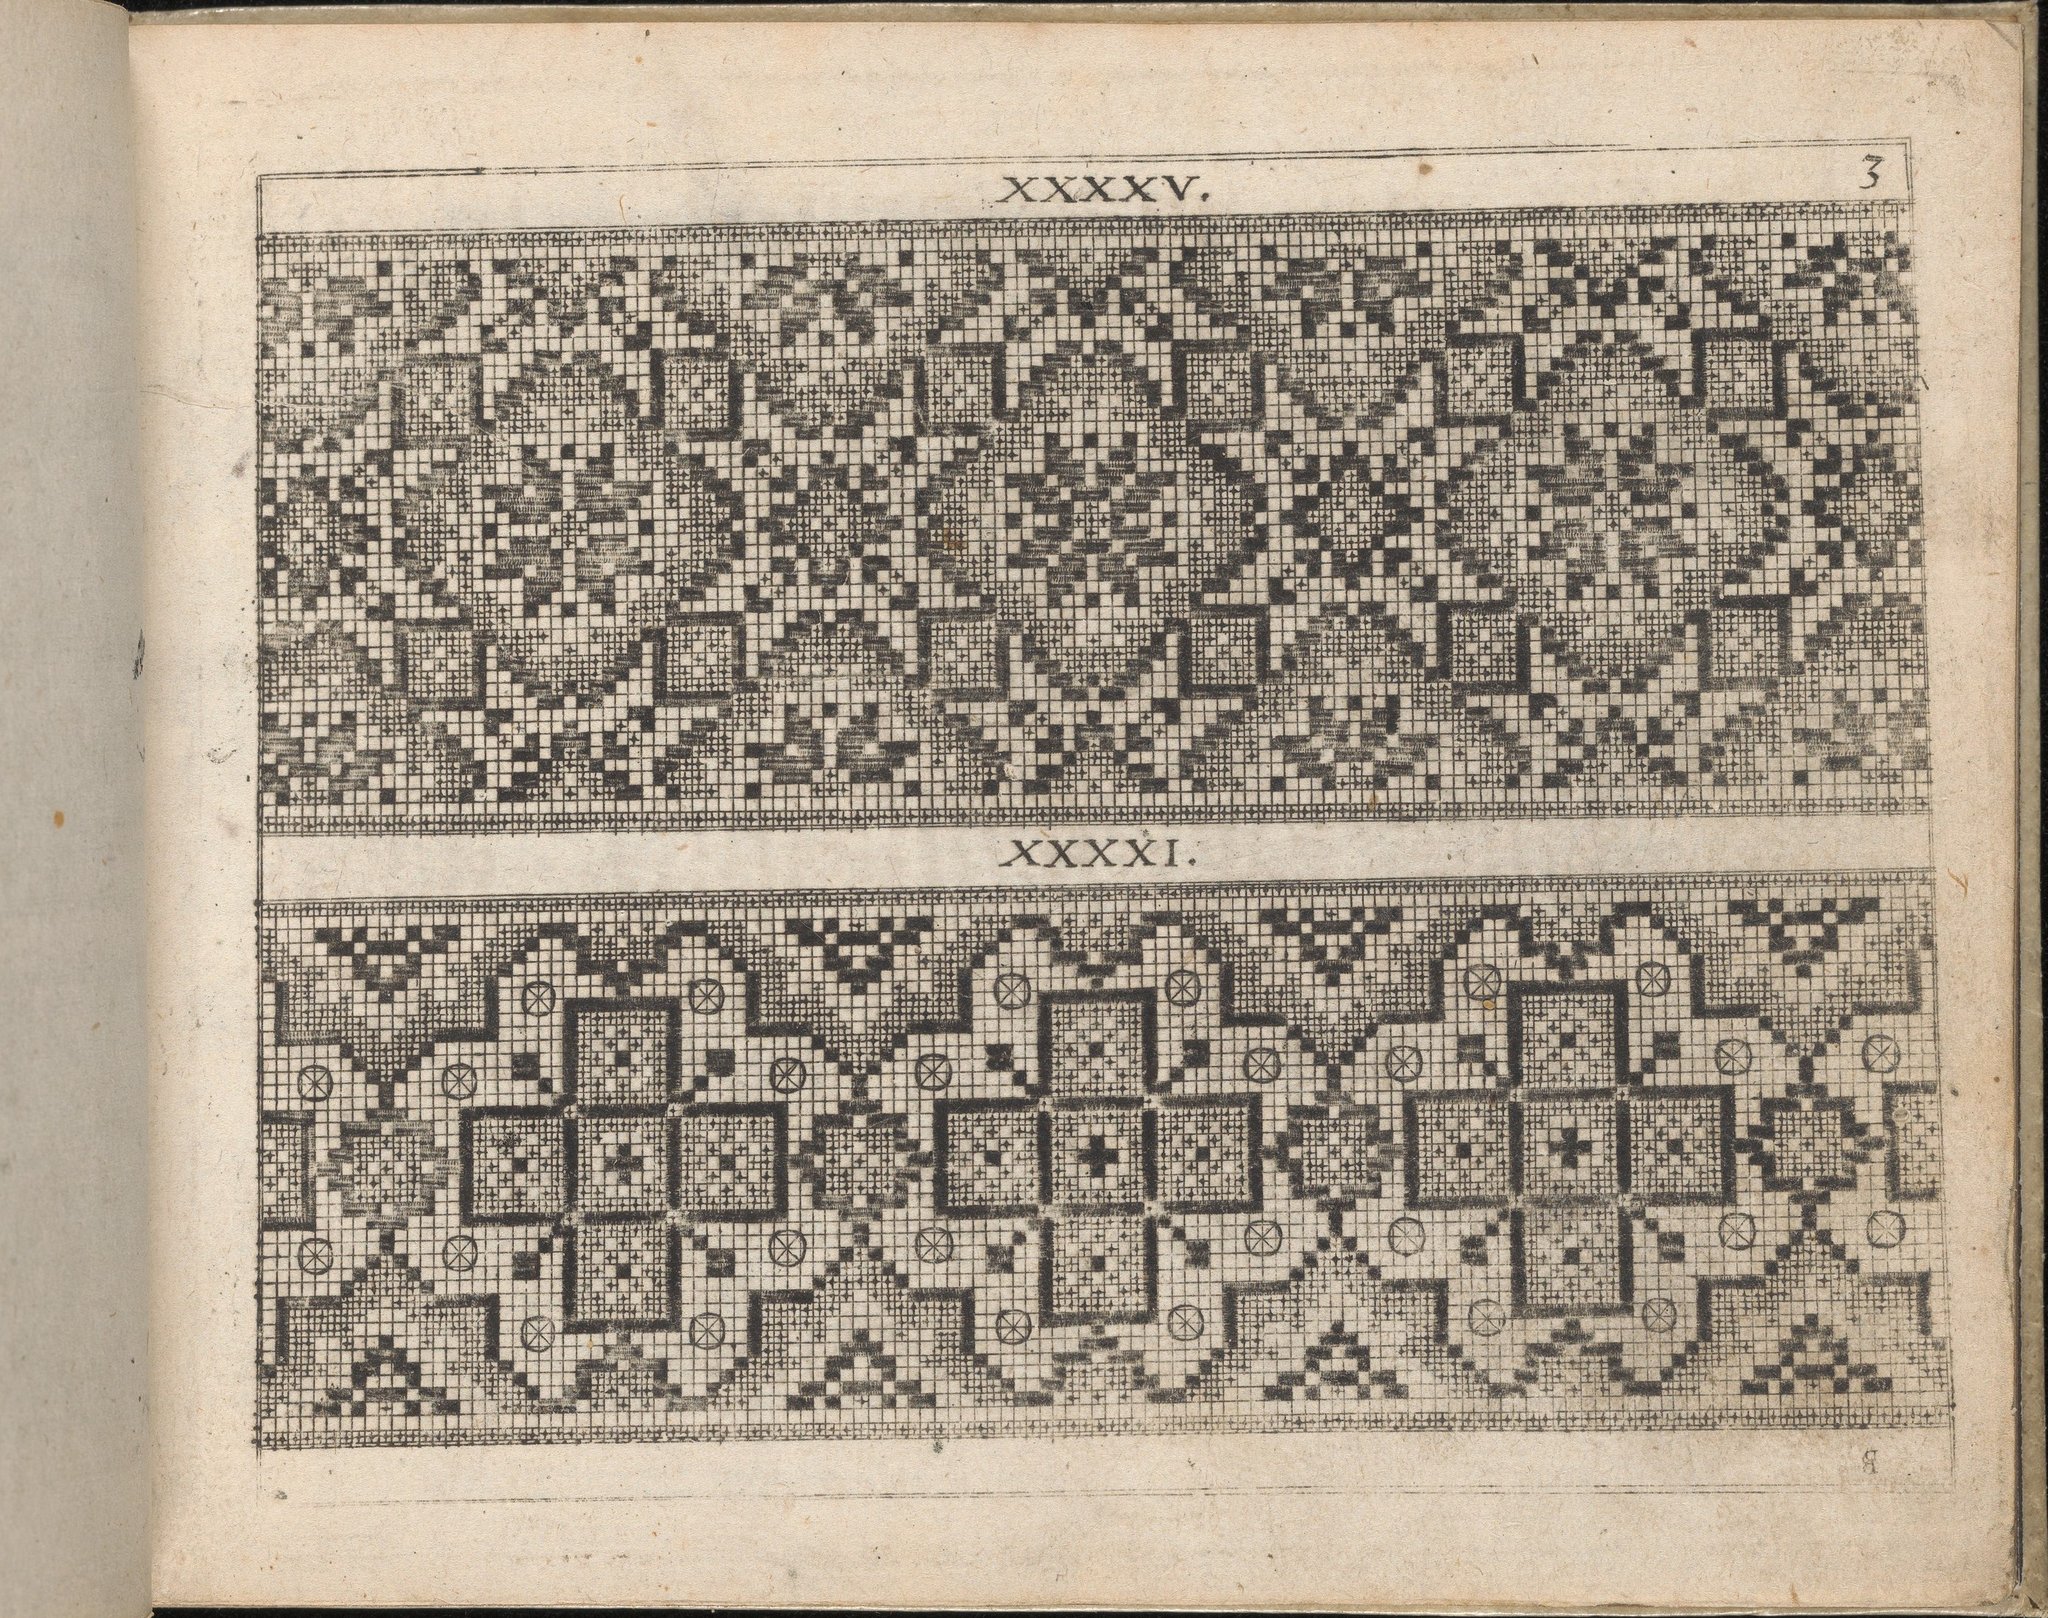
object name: book print ornament architecture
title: Newes Modelbuch in Kupffer (Page 12r)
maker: johann sibmacher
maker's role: artist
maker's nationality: german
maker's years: 1590-1611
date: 1604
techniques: etching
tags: ornament